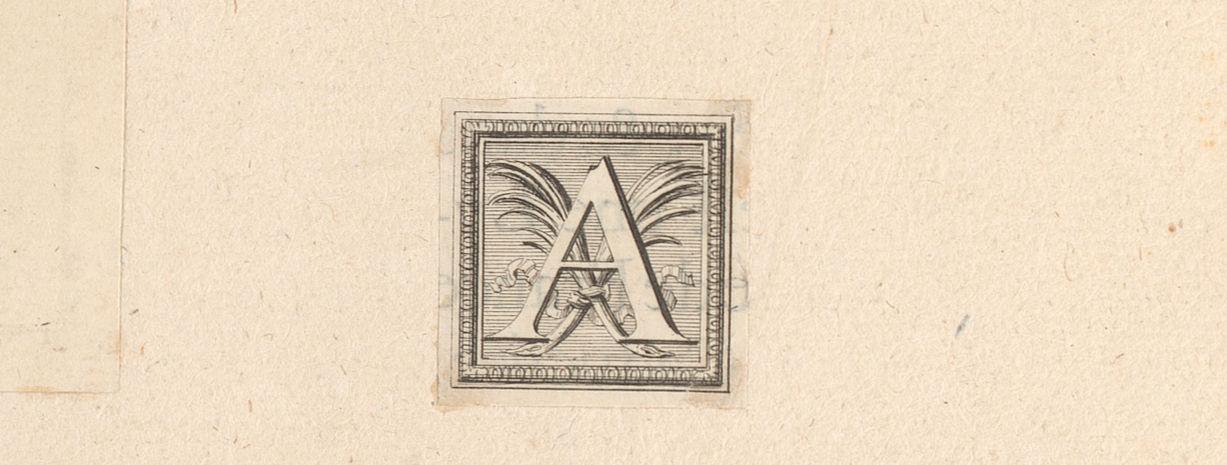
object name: book illustration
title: Initiaal 'A' met twee palmtakken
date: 1687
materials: paper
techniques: etching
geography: versailles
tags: initial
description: Initiaal uit: Rainssant, Pierre. Explication des tableaux de la galerie de Versailles (...). Versailles: François Muguet, 1687.